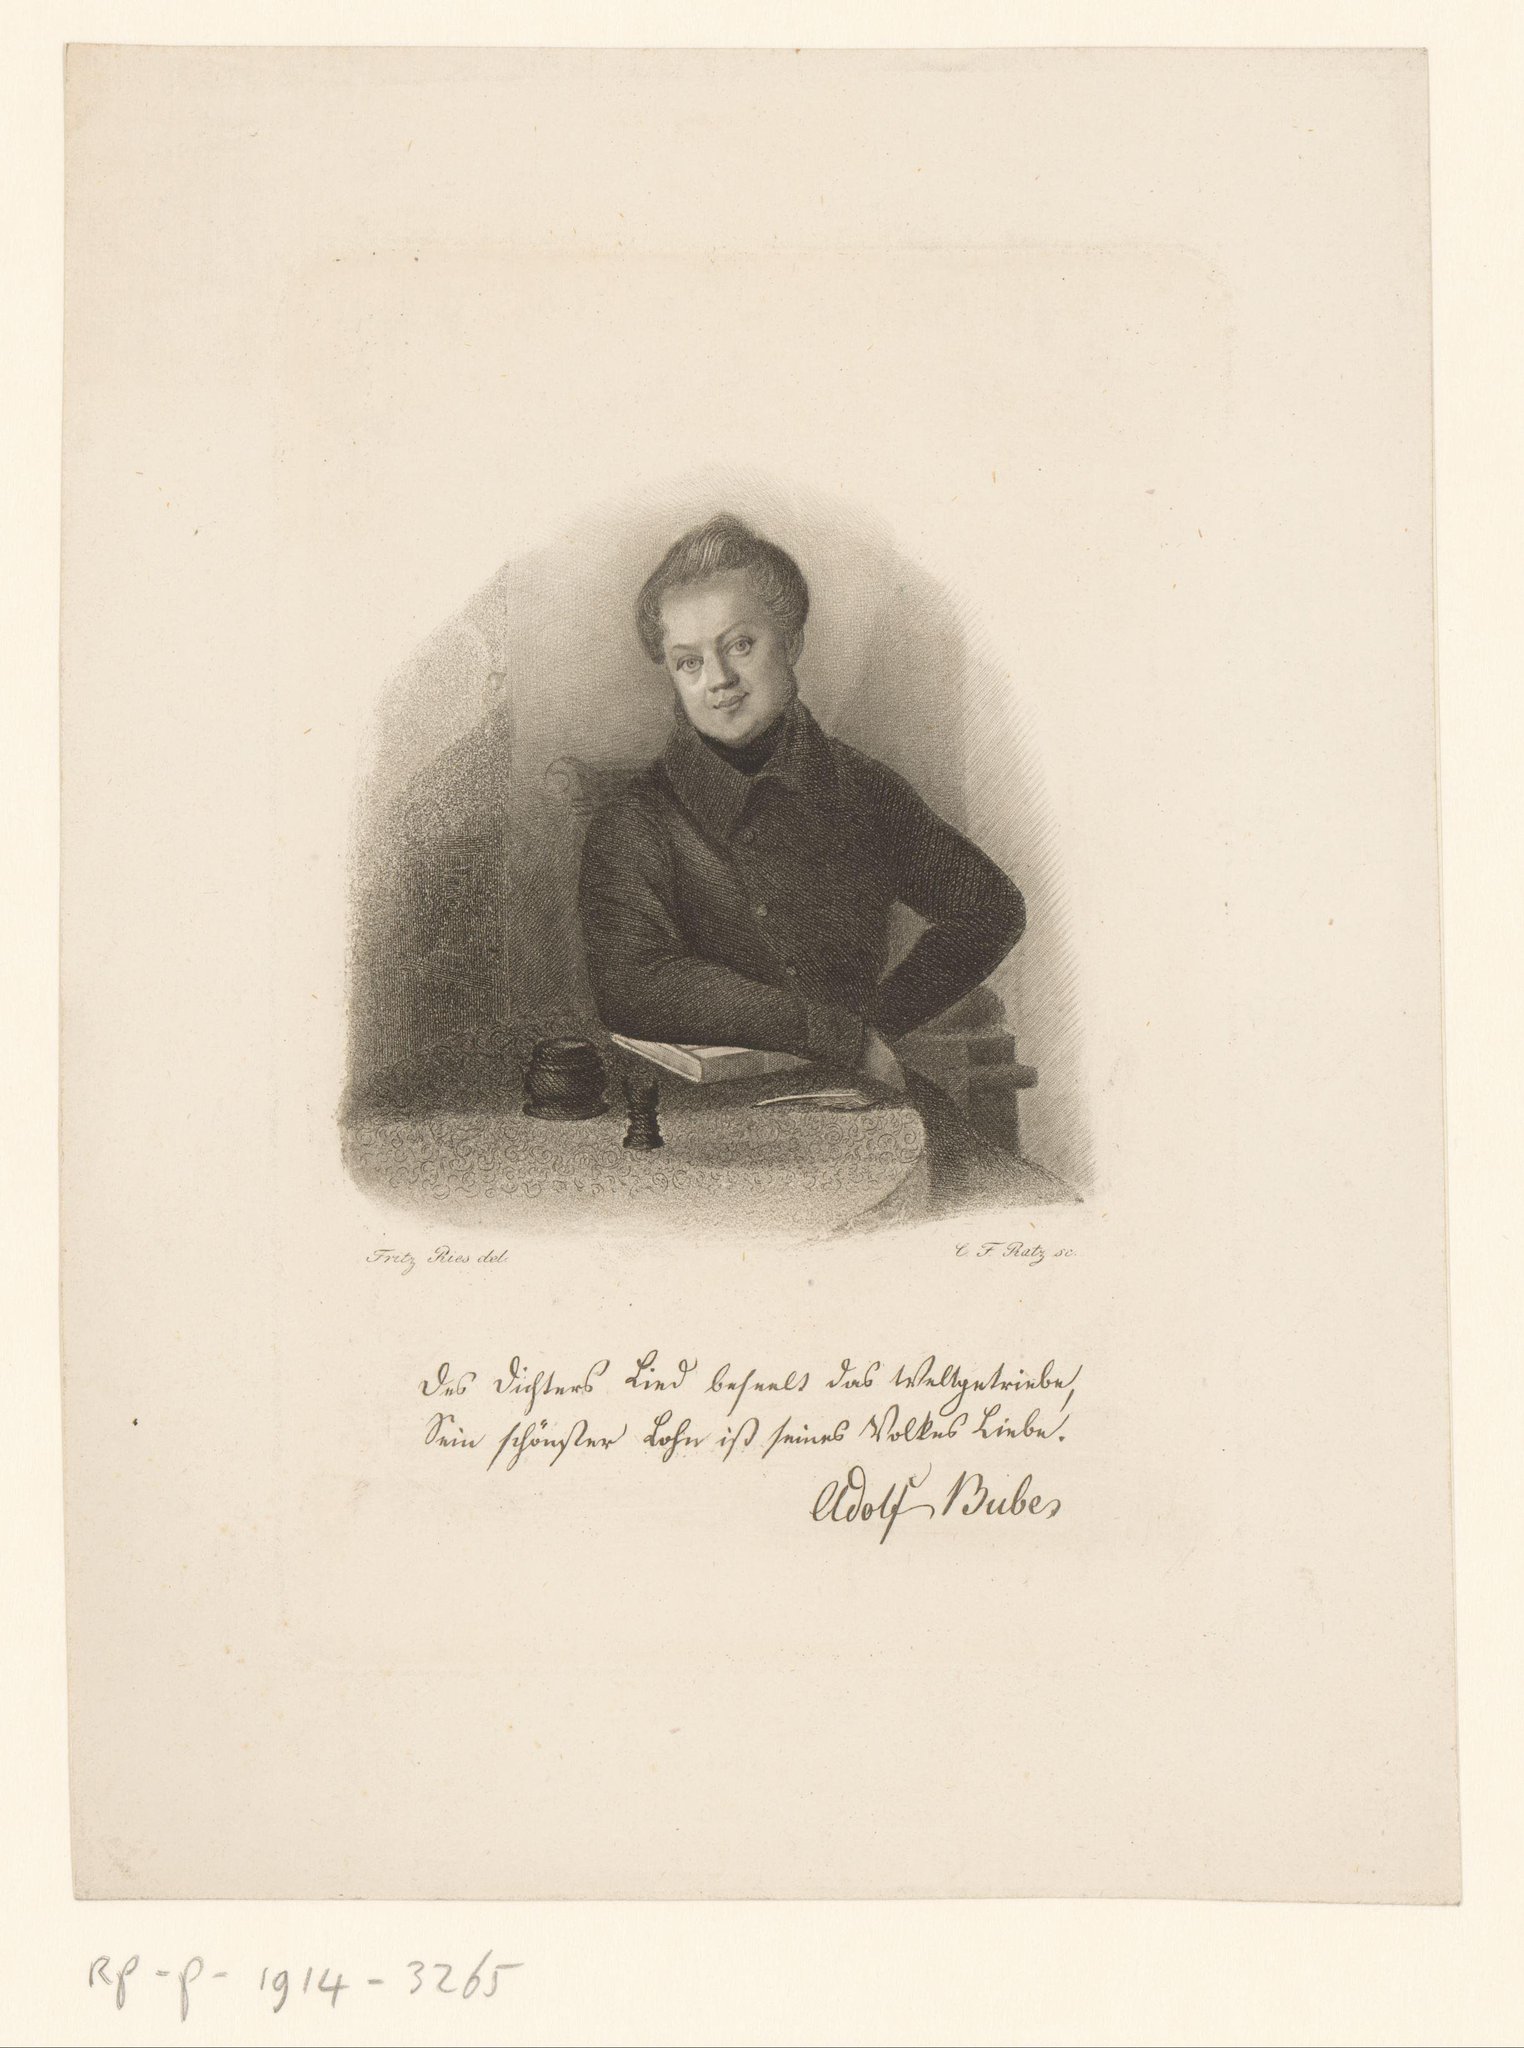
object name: print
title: Portret van Lind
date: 1800-1899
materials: paper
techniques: etching, roulette, soft ground etching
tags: historical persons - bb - woman, writing accessories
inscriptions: collector's mark: Lugt 2228